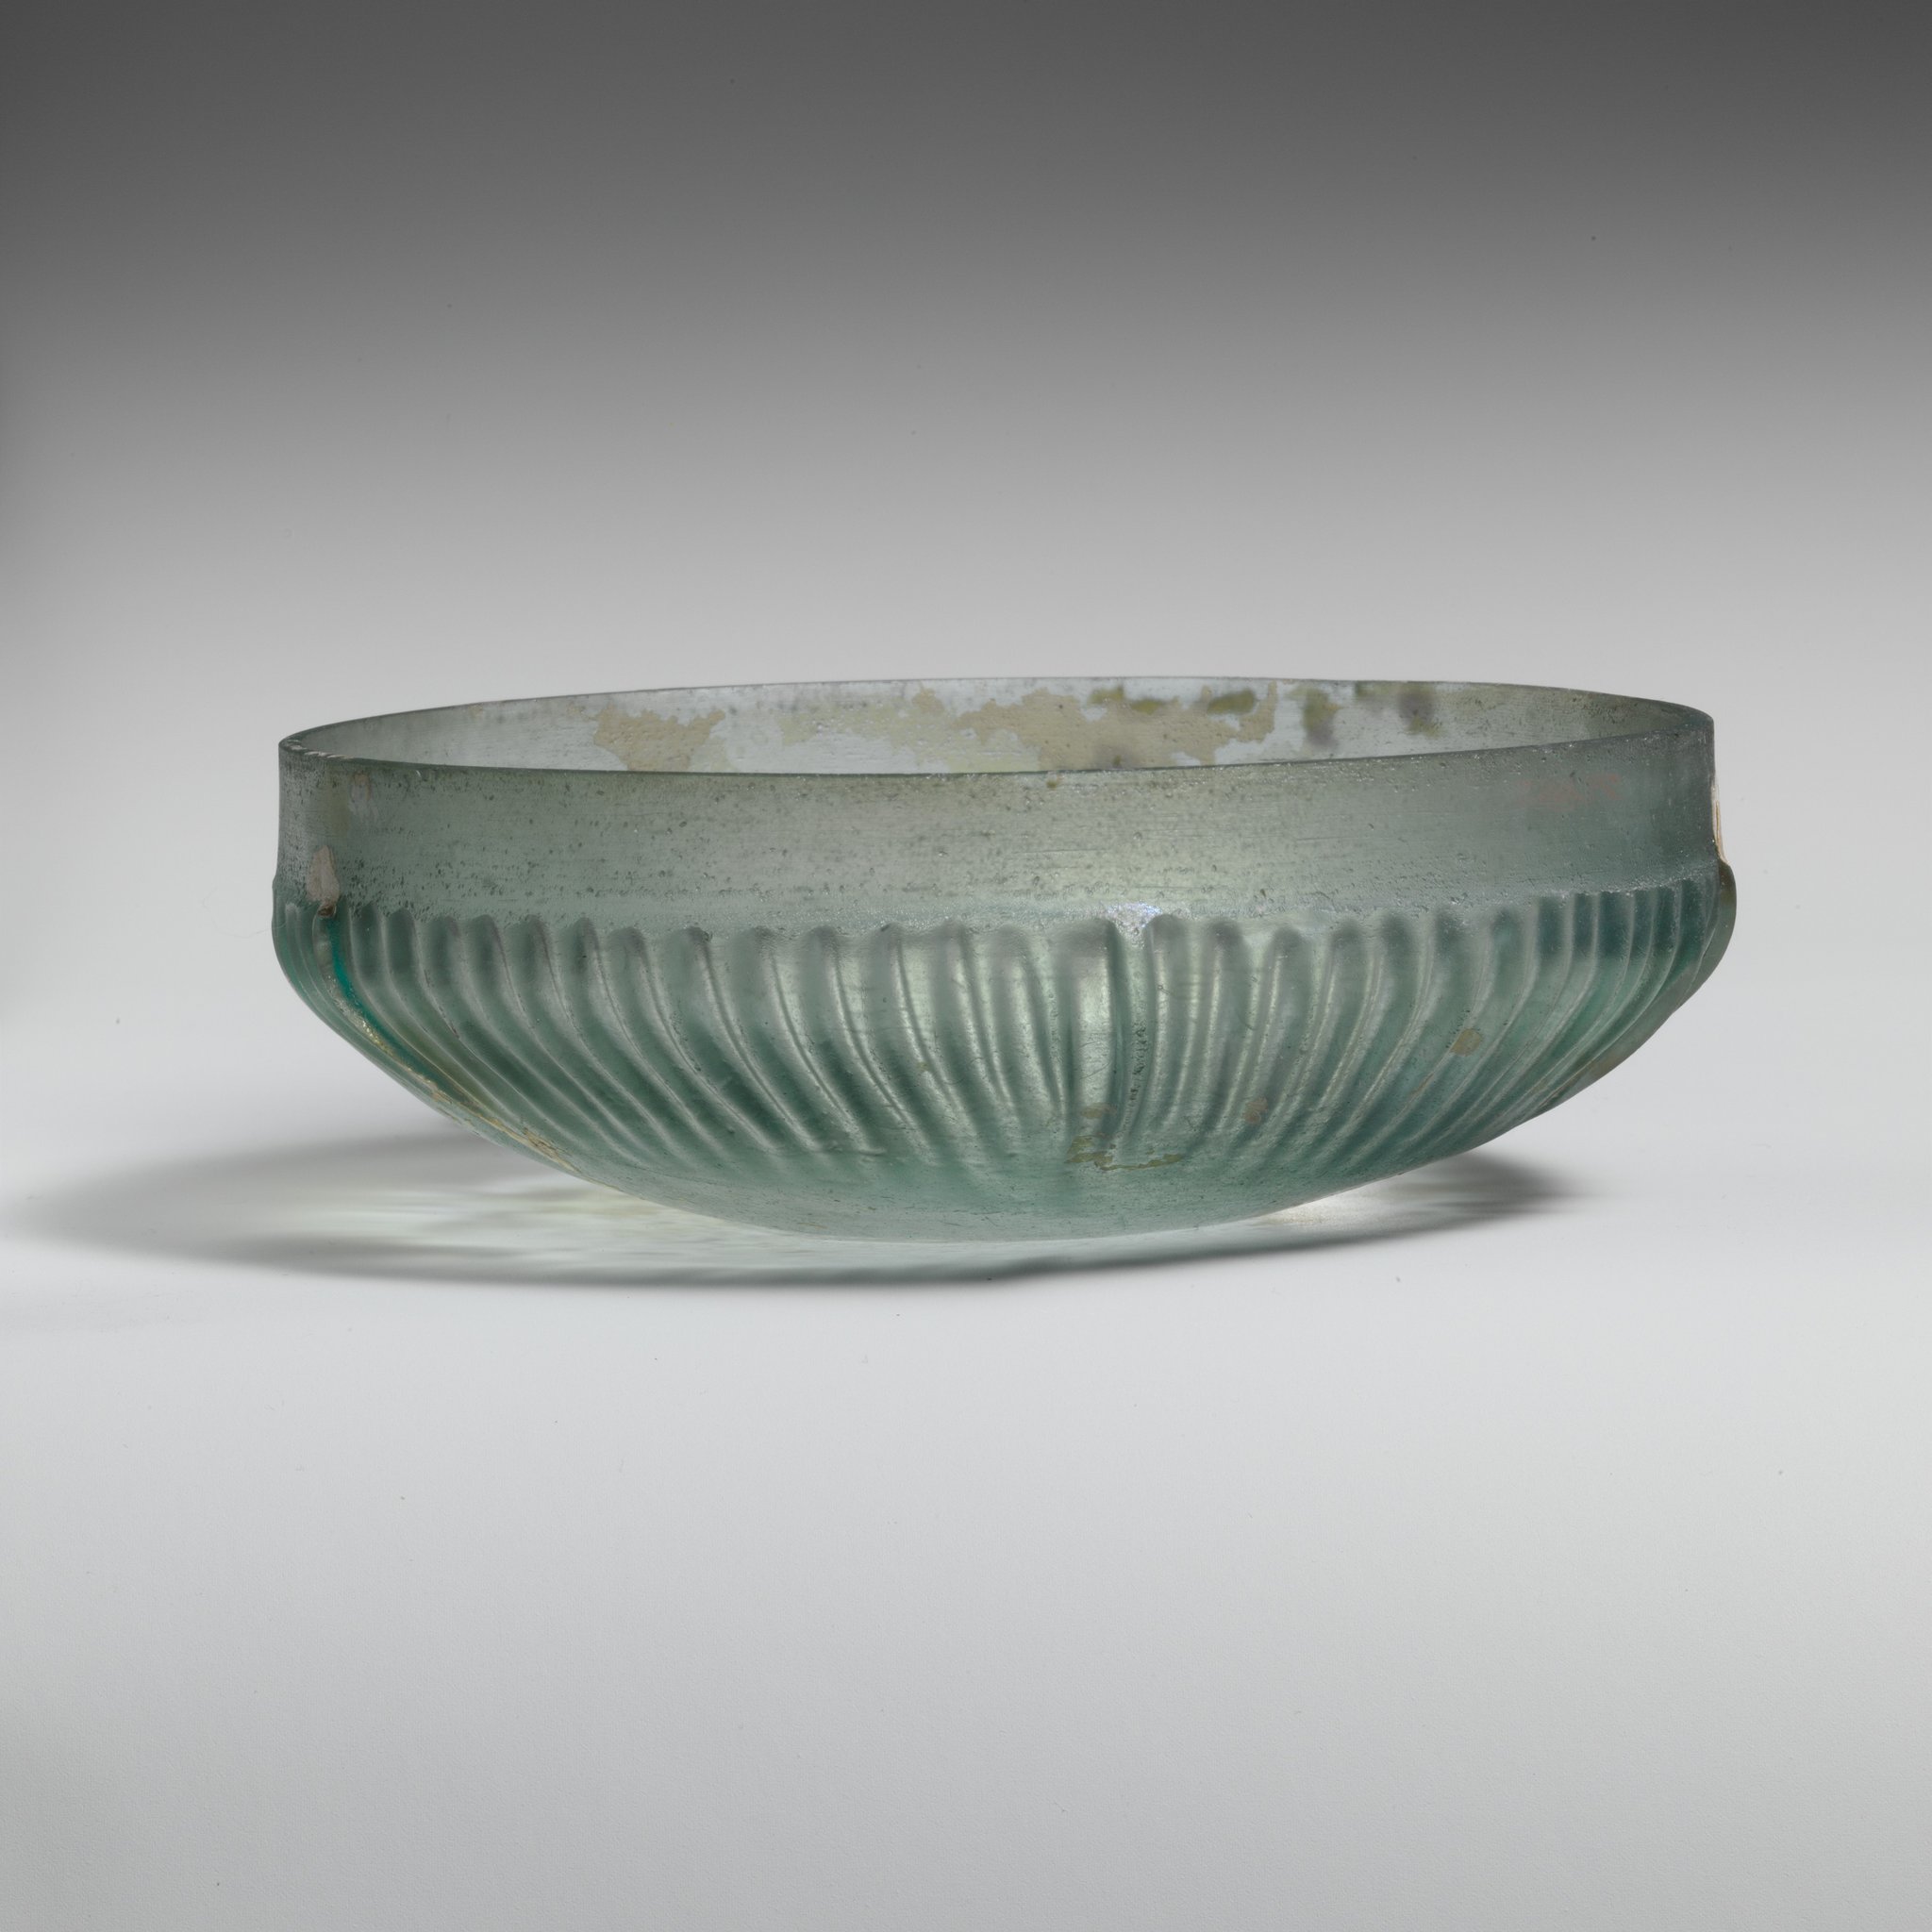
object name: bowl, ribbed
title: Glass ribbed bowl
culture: roman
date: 67-100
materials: glass